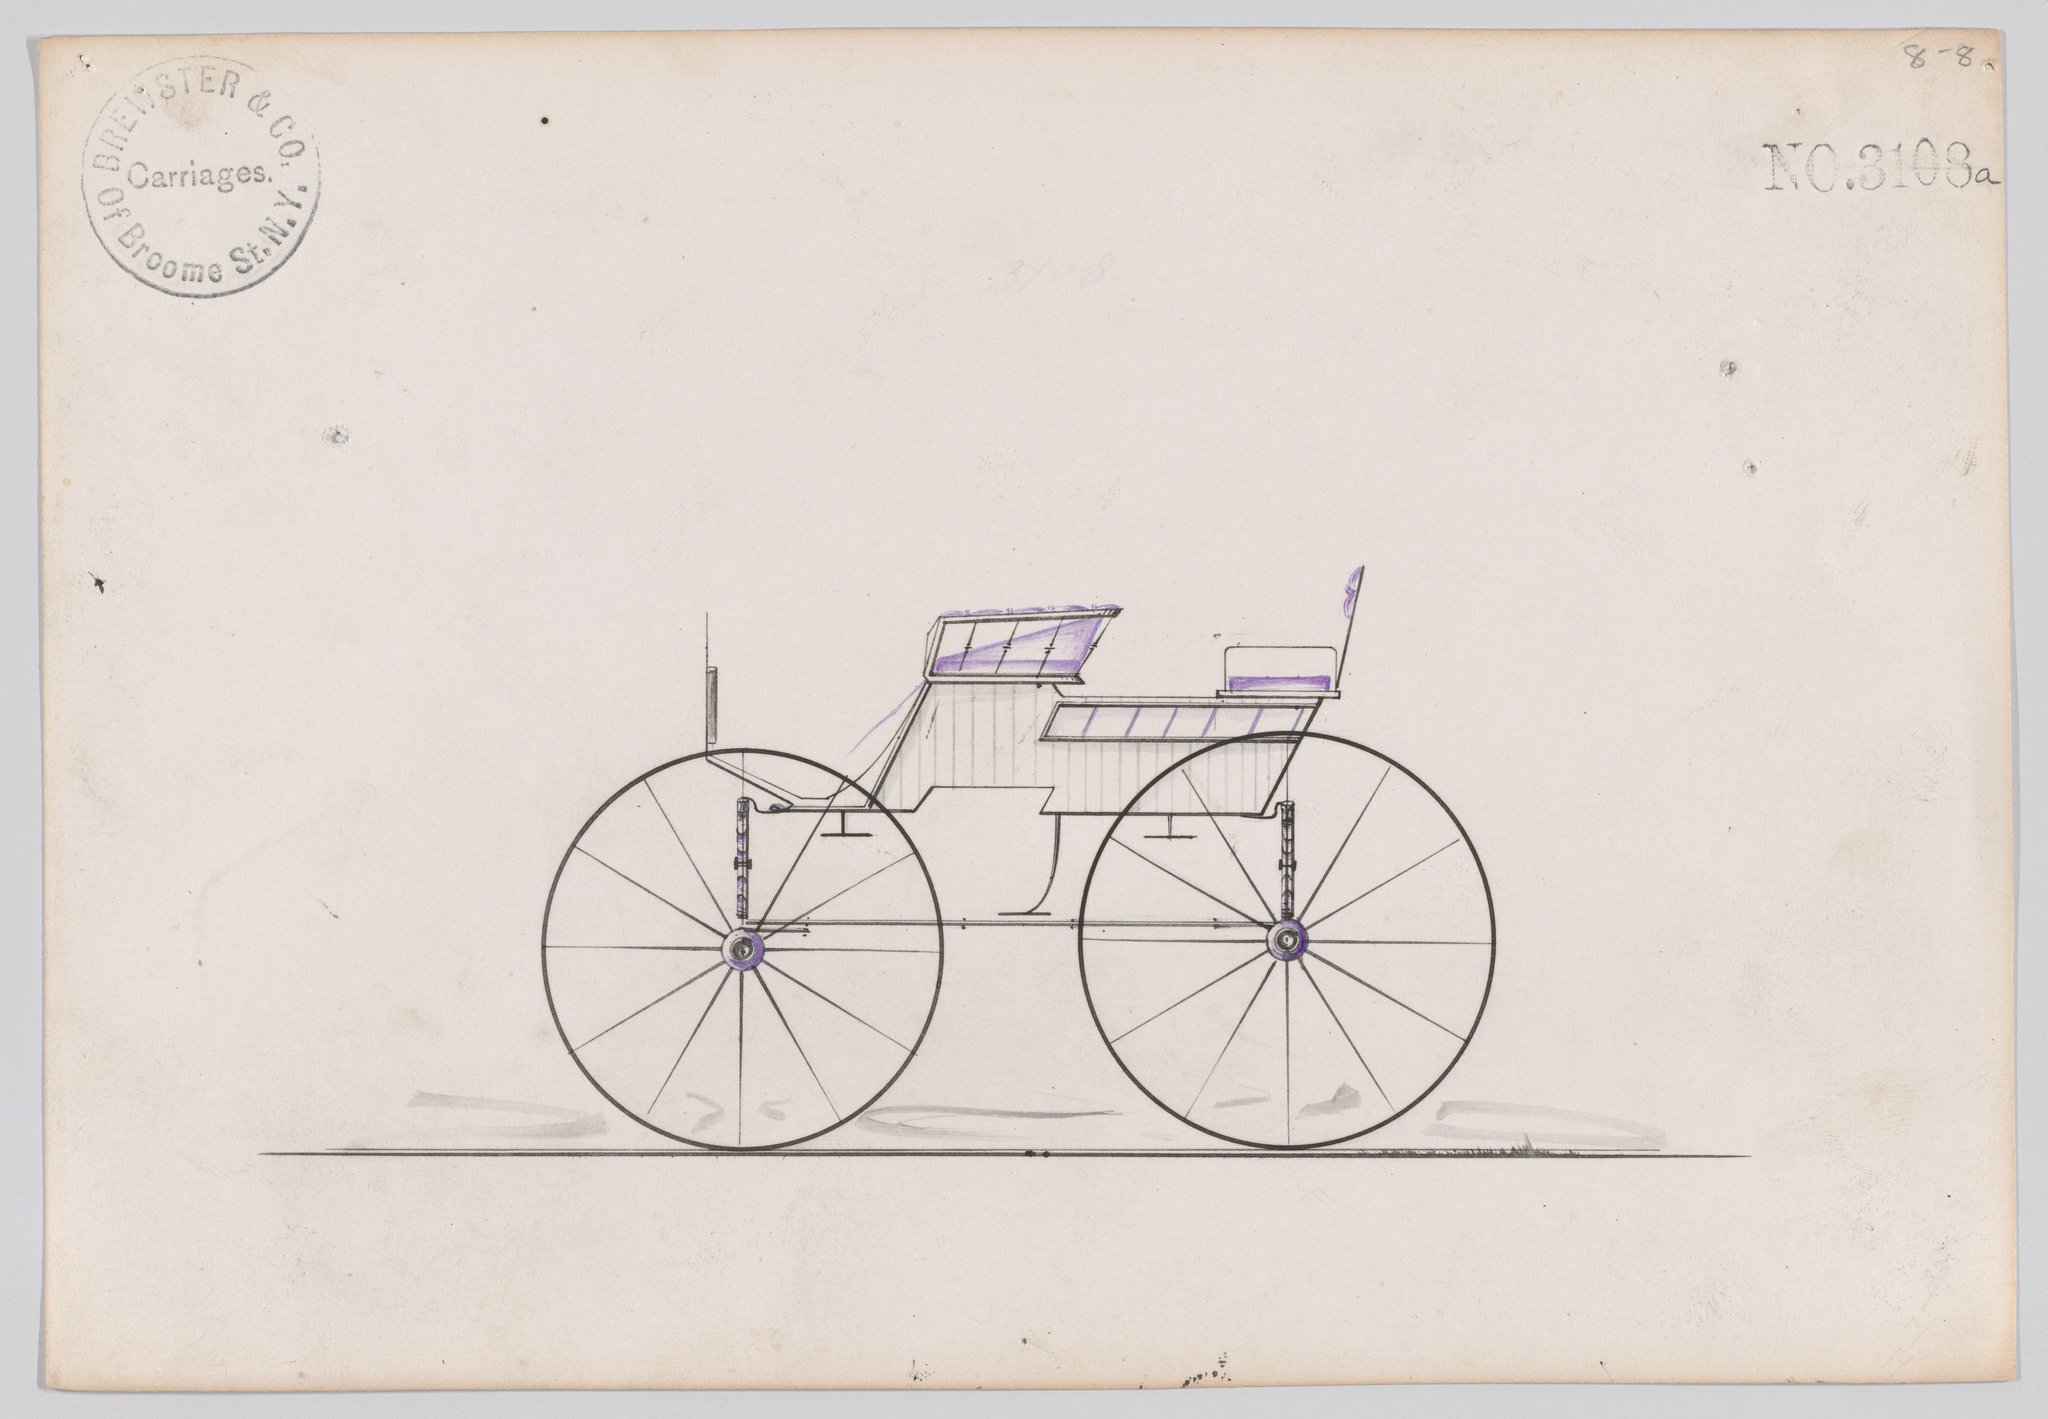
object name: drawing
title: Design for 4 seat Phaeton, no top, no. 3108a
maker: brewster & co.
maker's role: manufacturer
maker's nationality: american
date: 1875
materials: gouache, ink, watercolor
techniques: pen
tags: carriages